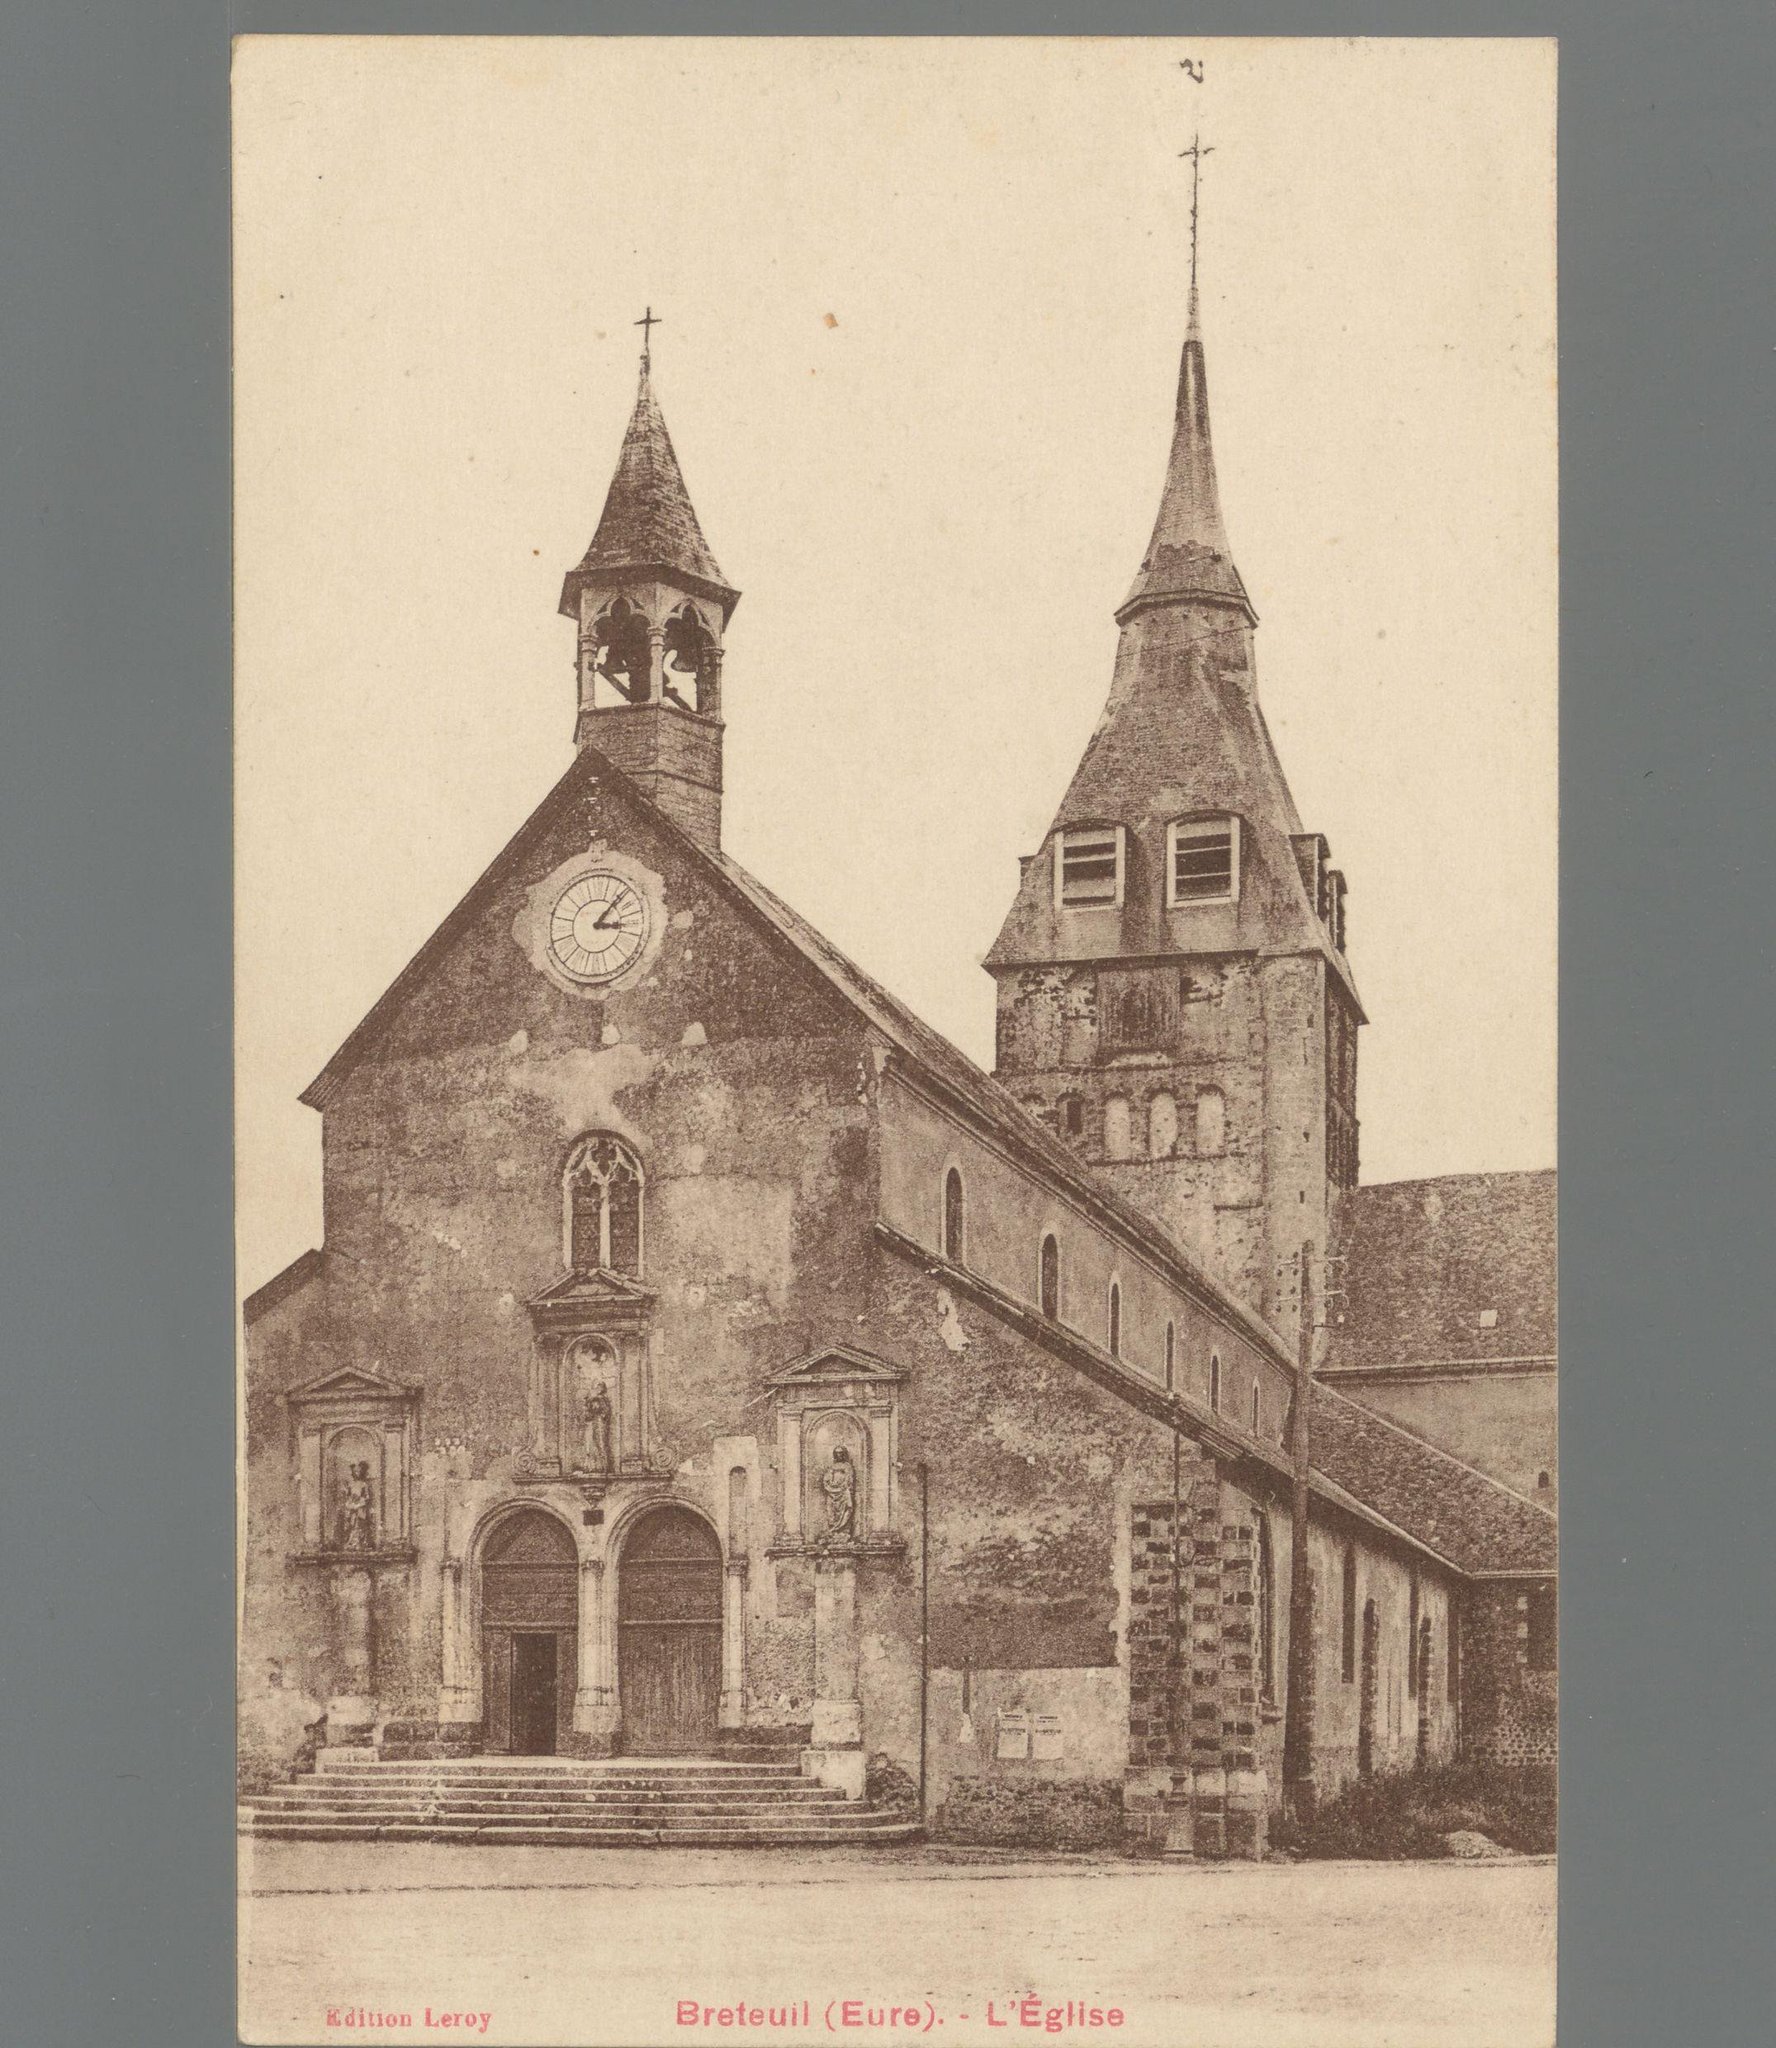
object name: photomechanical print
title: Edition Leroy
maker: Anonymous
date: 1903-1930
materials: cardboard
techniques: photograph, writing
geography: paris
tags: church (exterior)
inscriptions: collector's mark: ‘AFE v S’, postage stamp